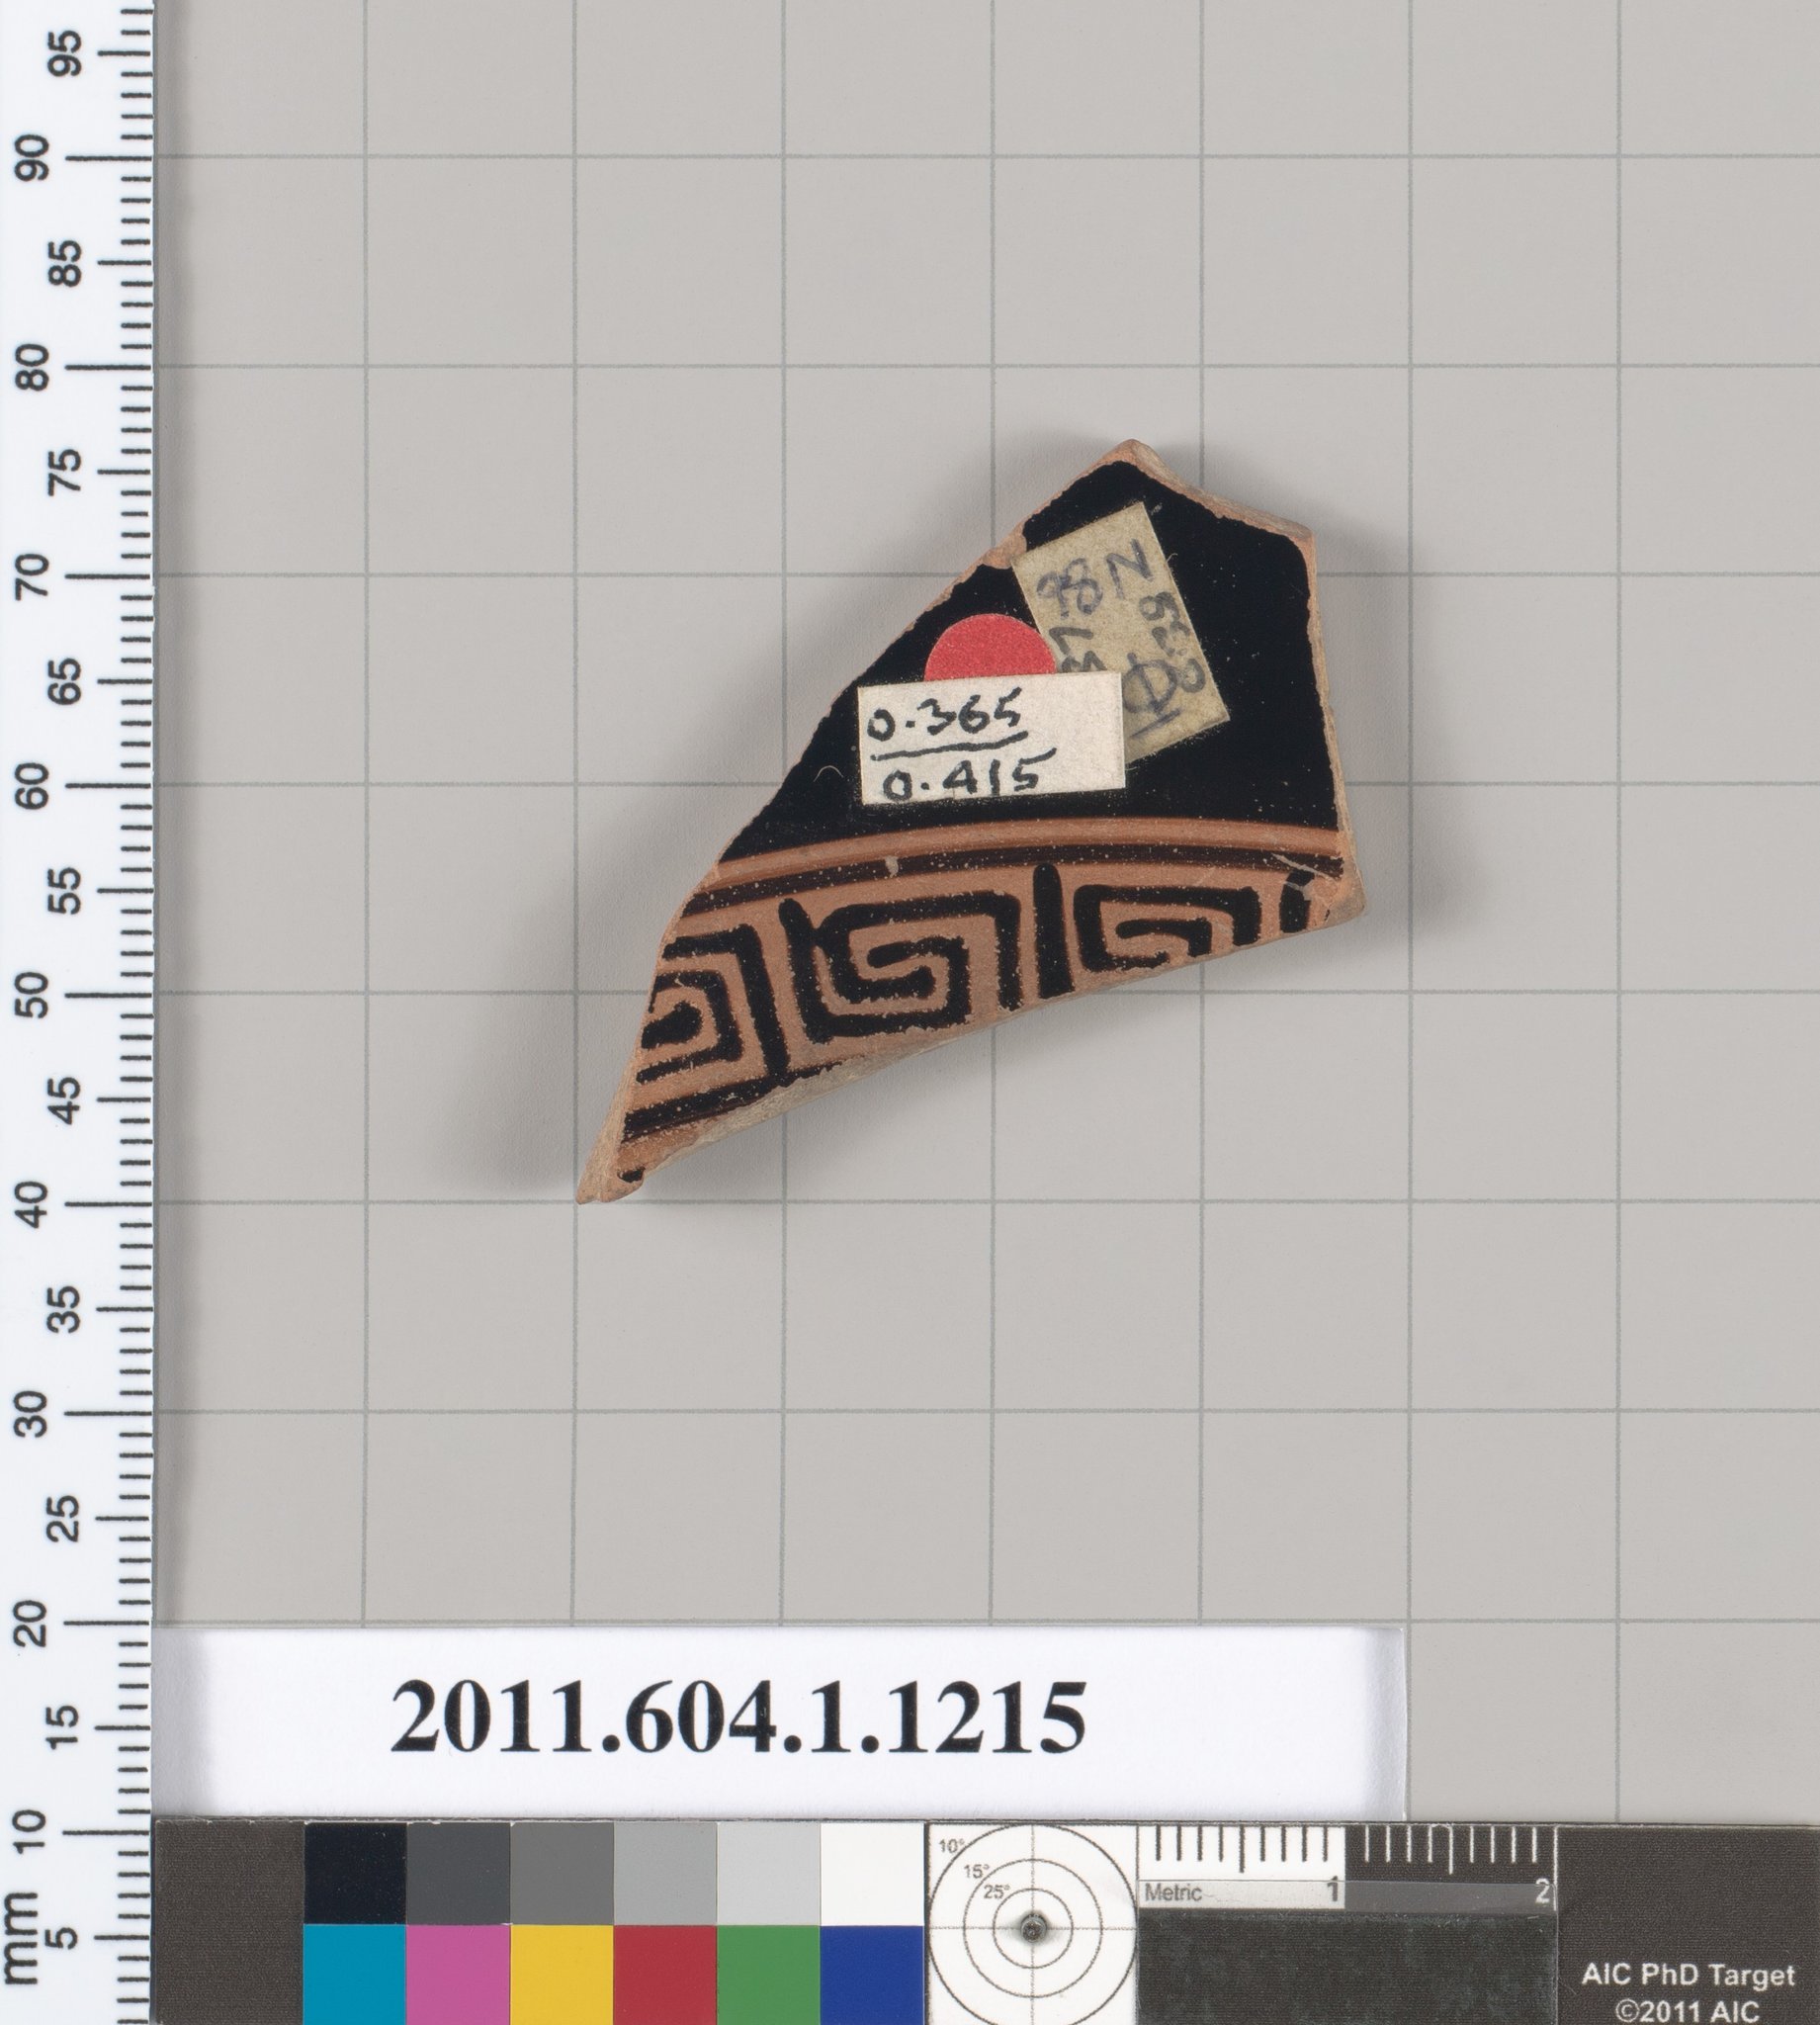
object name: kylix fragment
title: Terracotta fragment of a kylix (drinking cup)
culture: greek, attic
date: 490-480 BCE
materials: terracotta